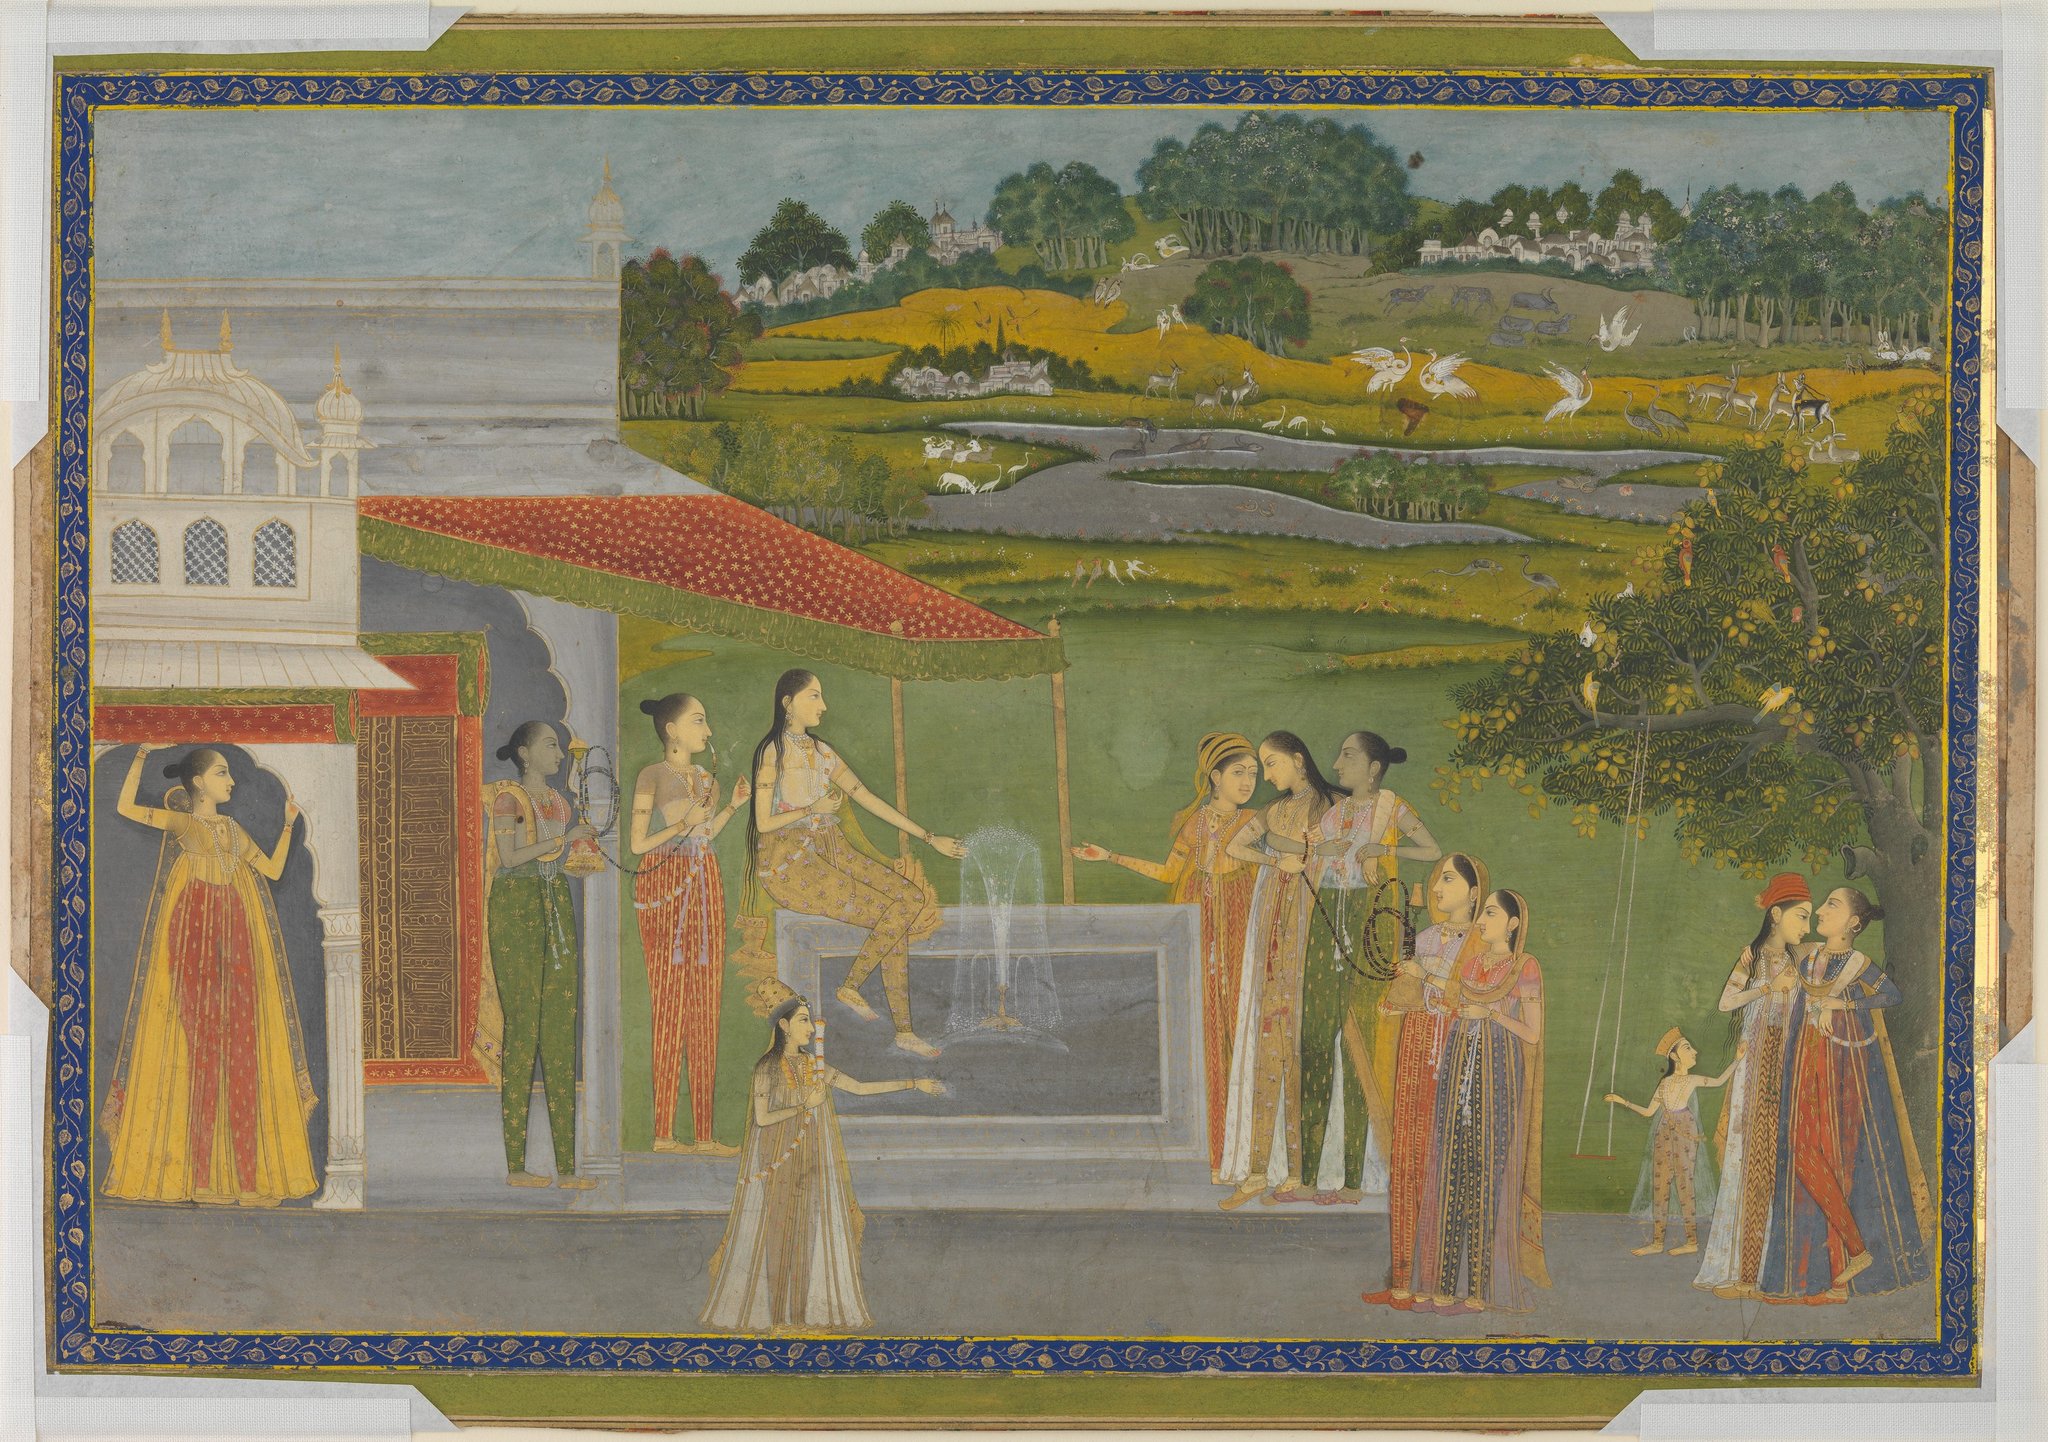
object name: illustrated single work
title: Princesses Gather at a Fountain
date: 1770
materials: gold, paper, watercolor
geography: india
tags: fountains,princesses,swans,landscapes